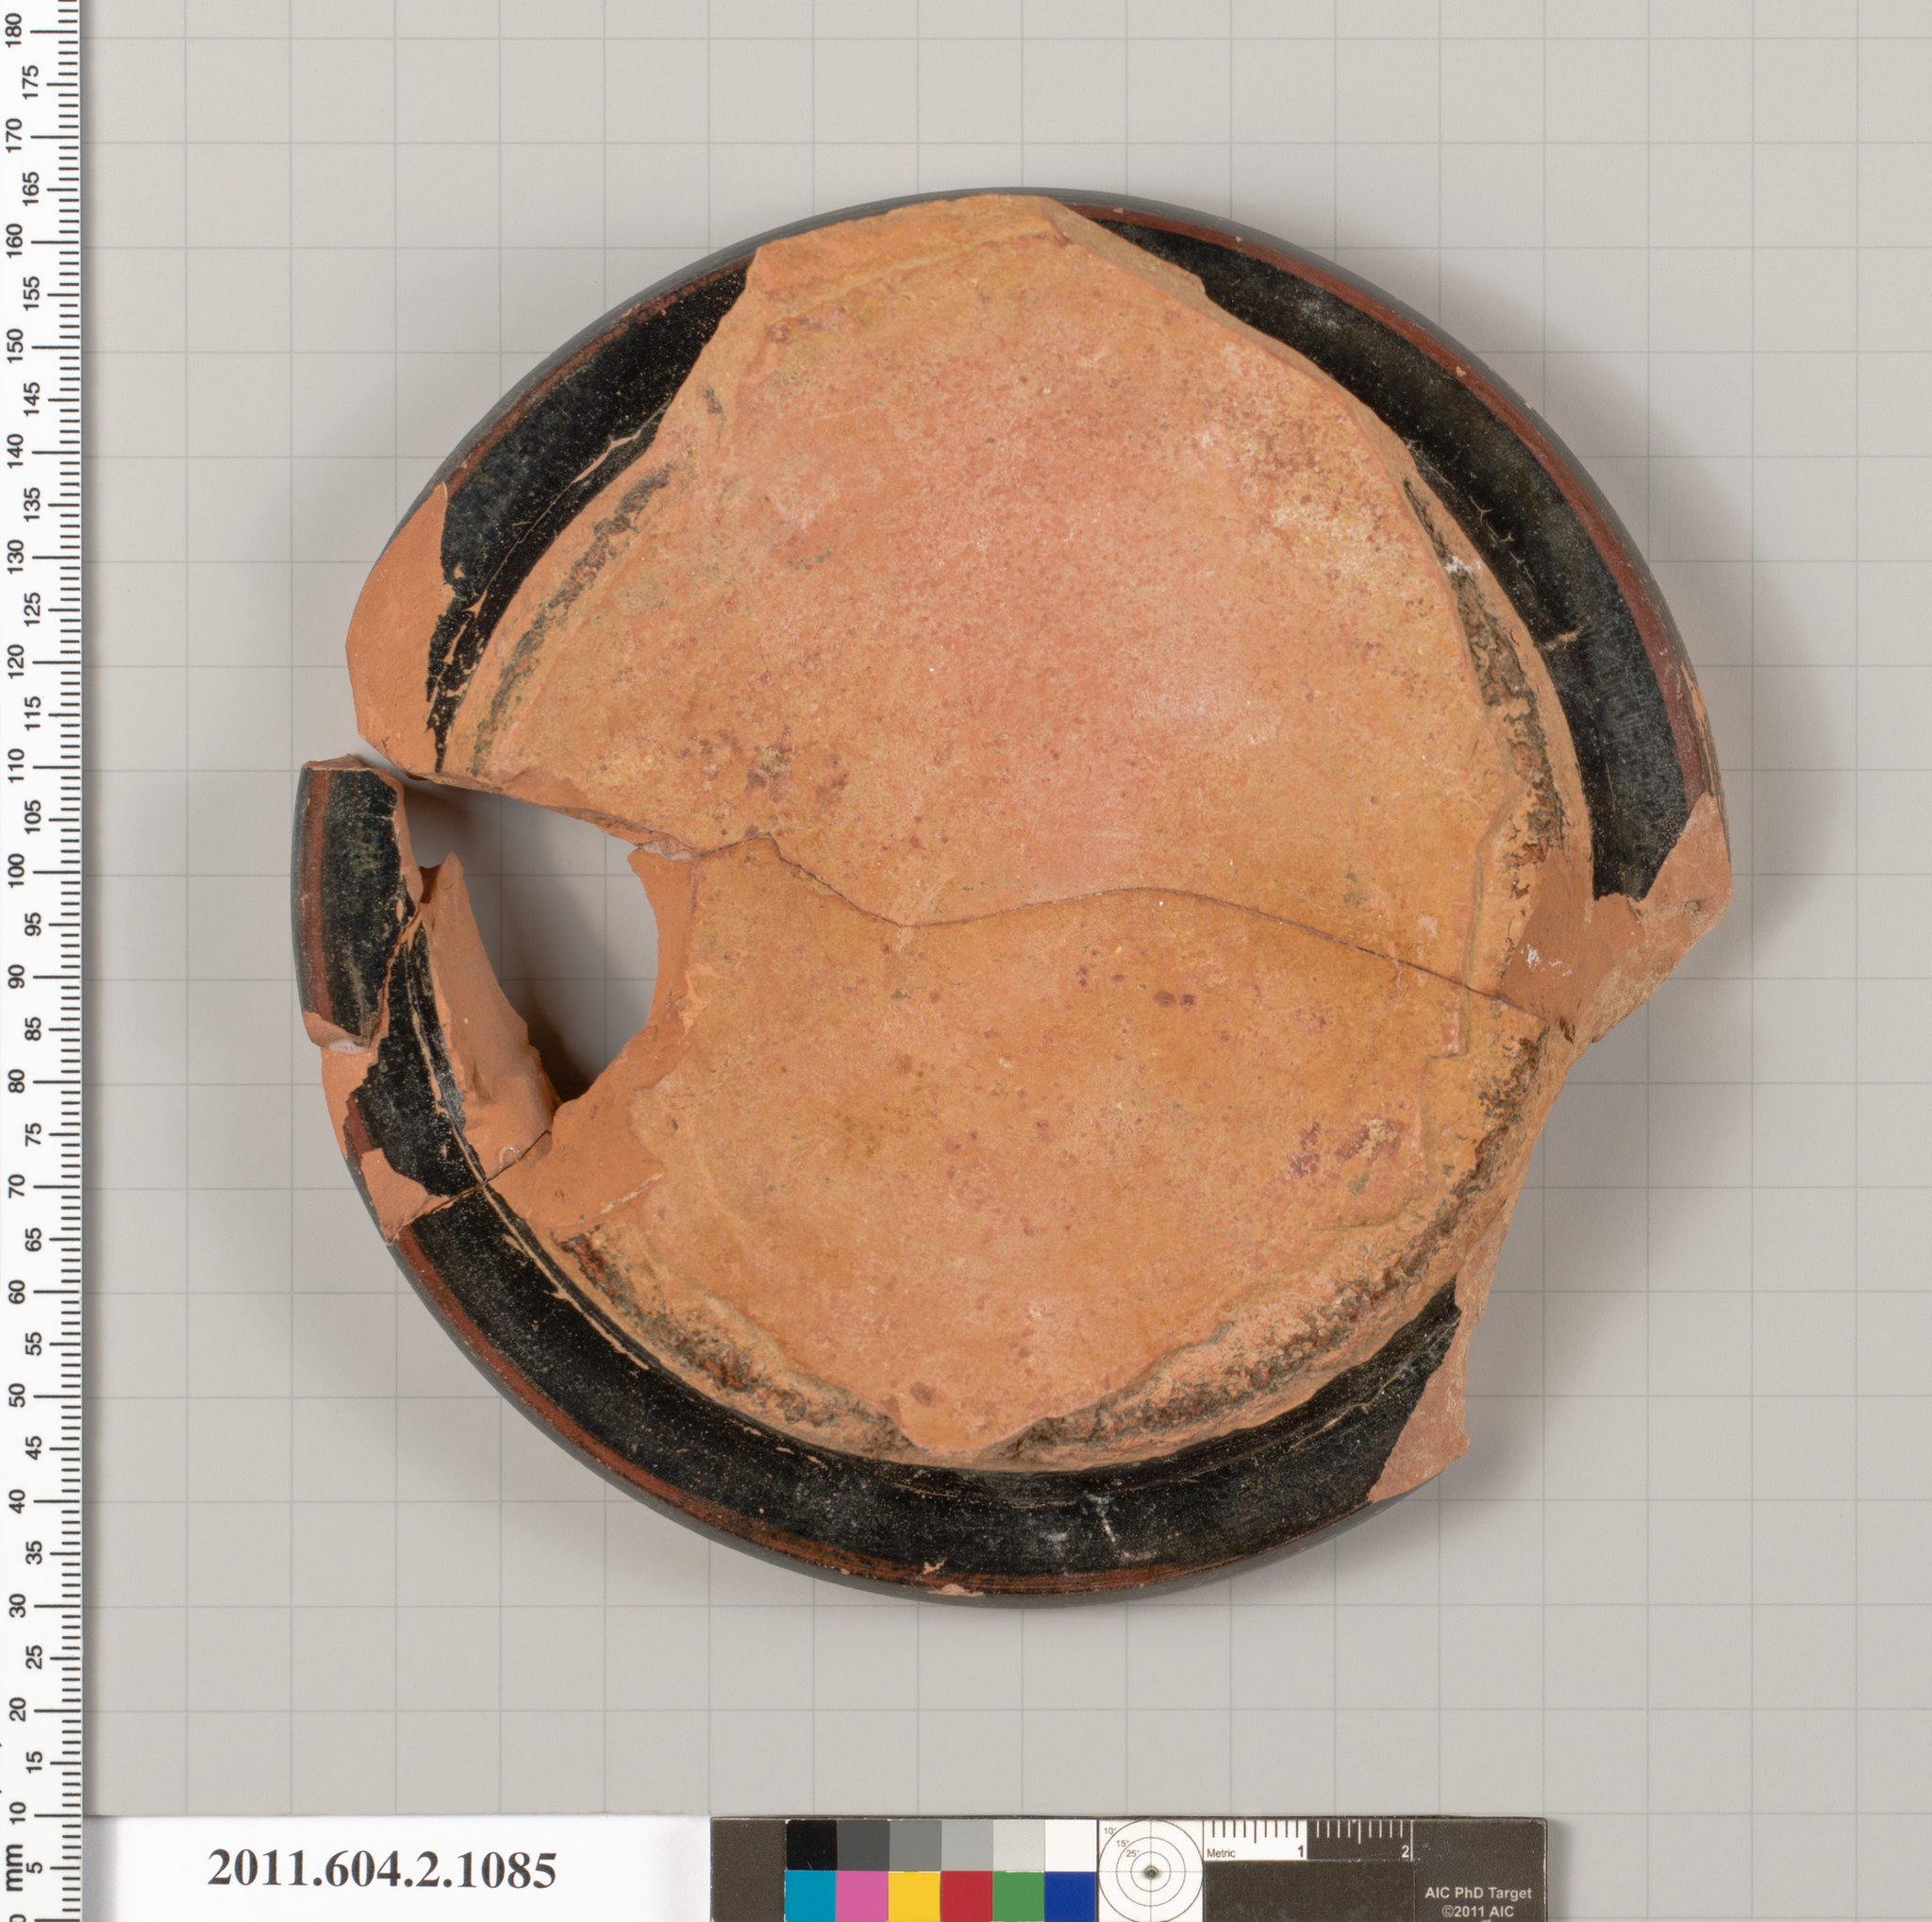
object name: hydria fragment or pelike fragment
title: Terracotta fragment of a hydria (water jar) or terracotta fragment of a pelike (jar)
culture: greek, attic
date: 534-468 BCE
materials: terracotta